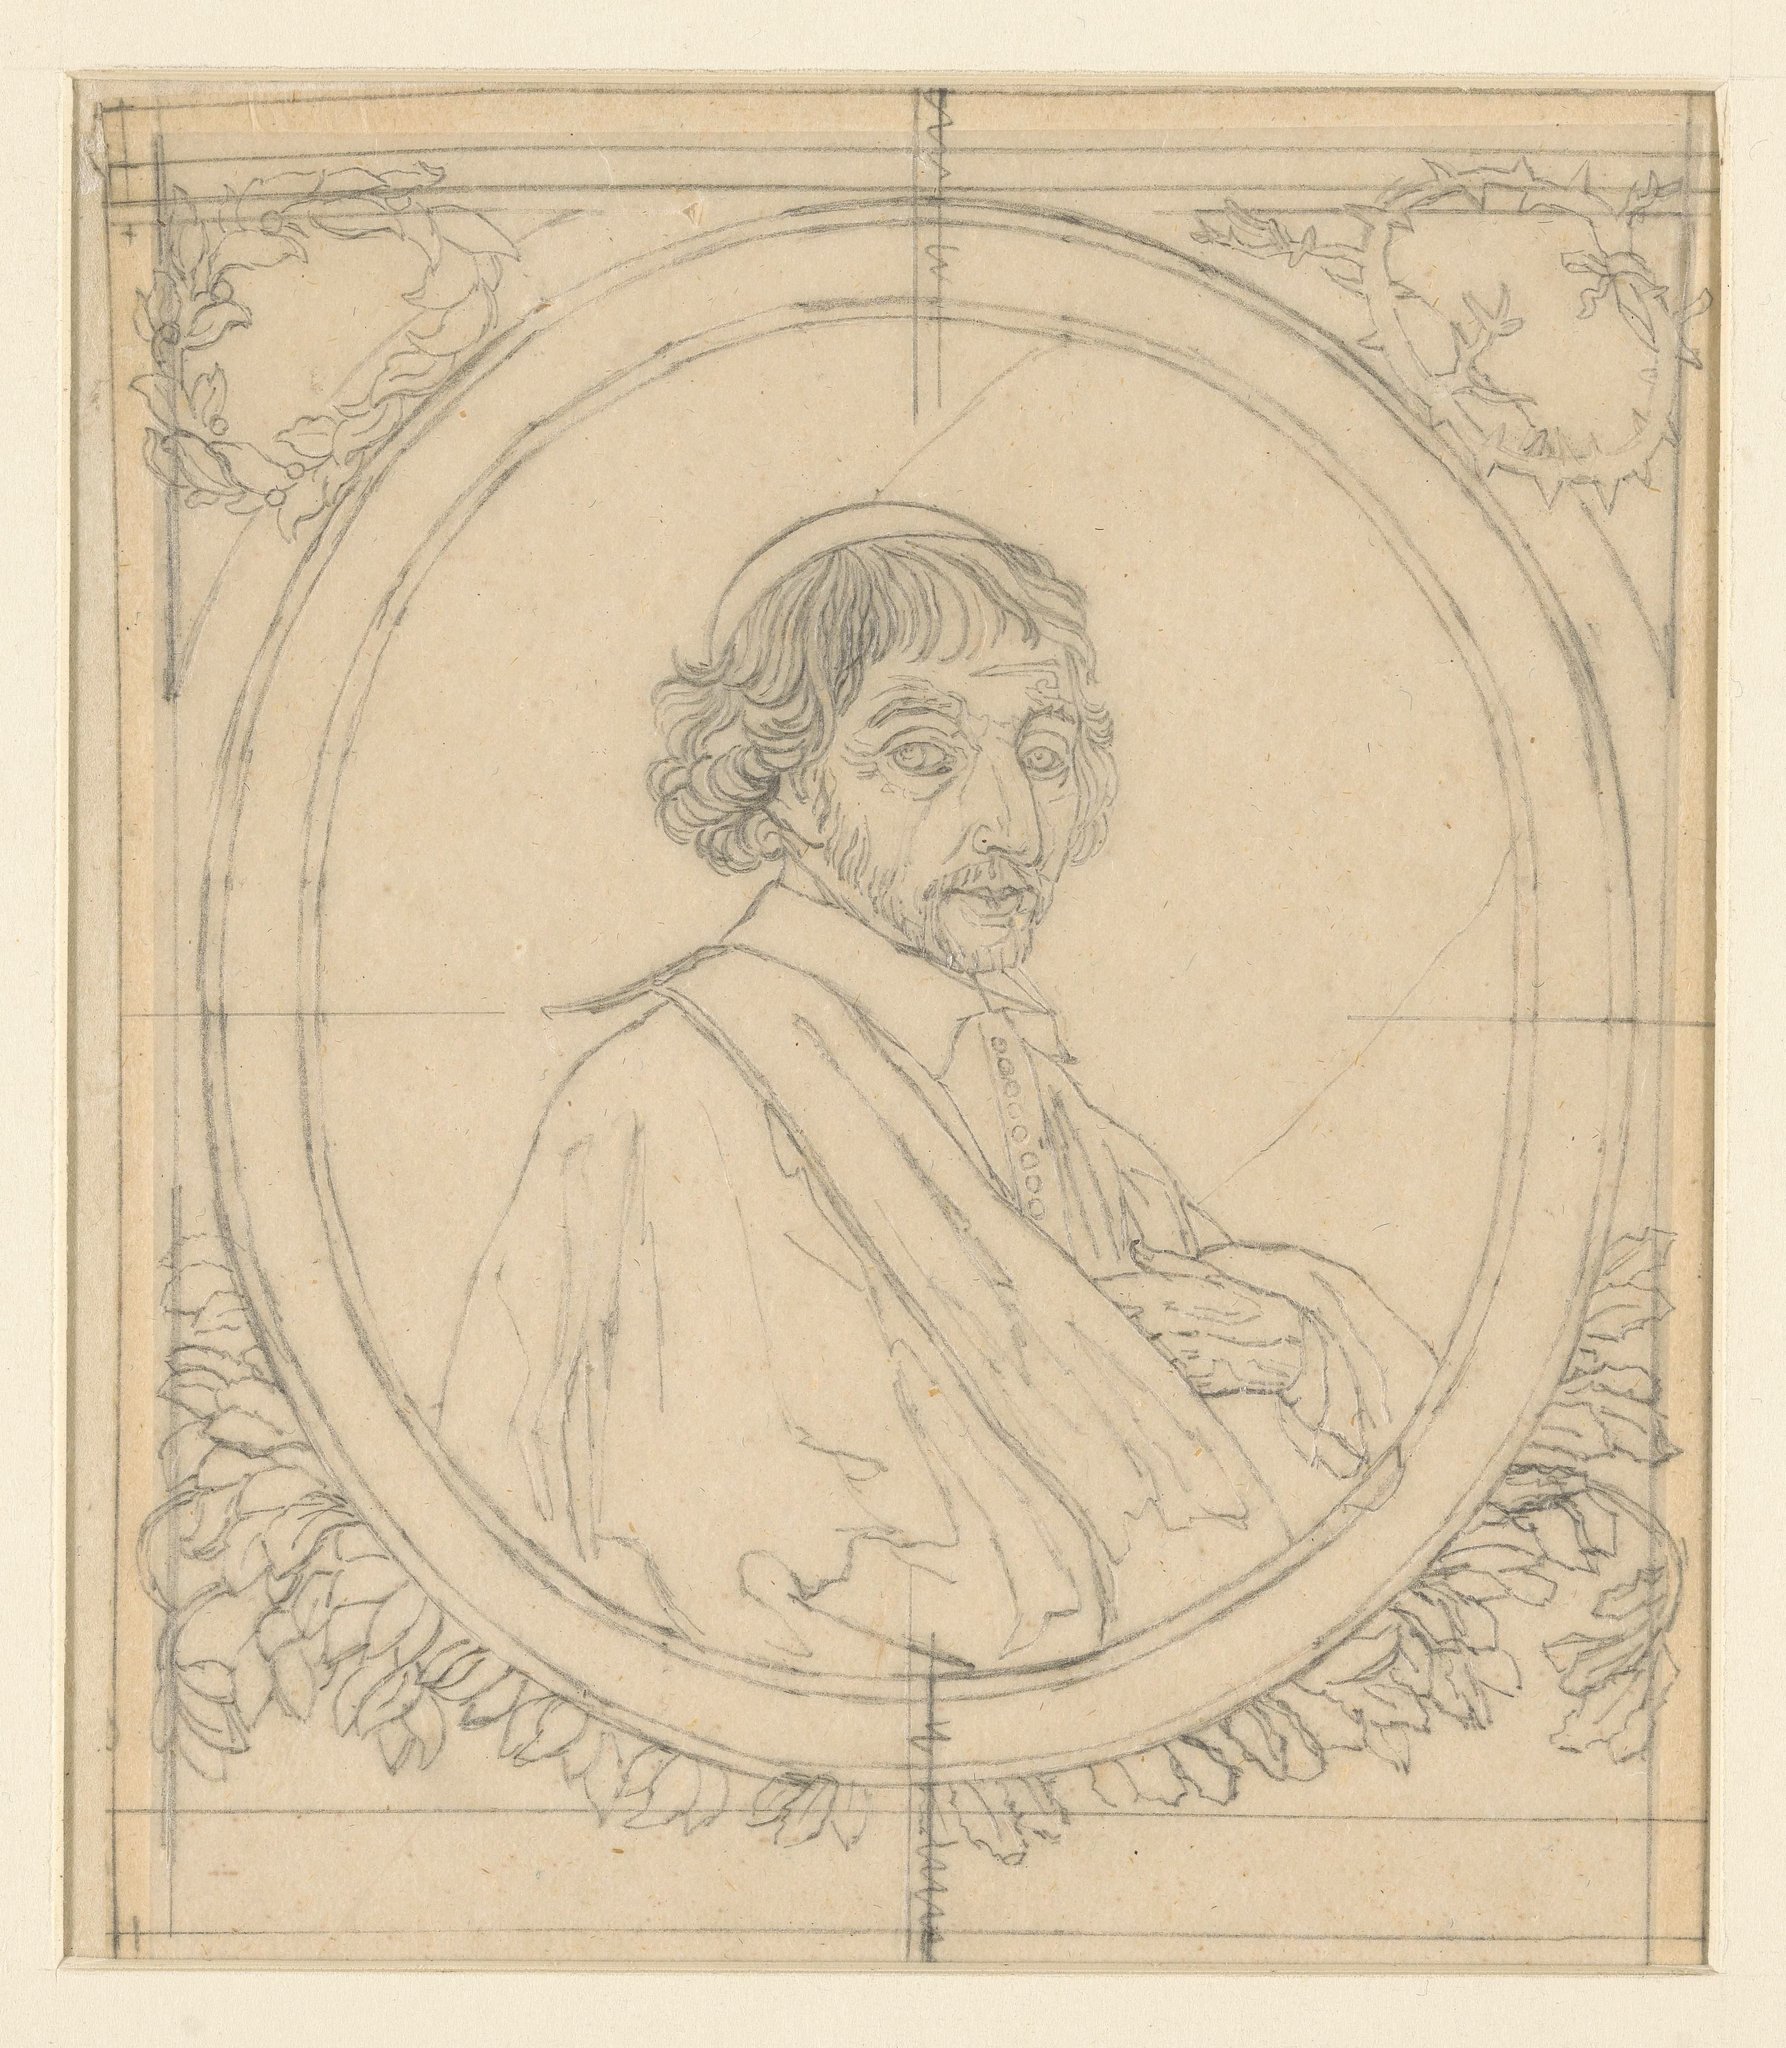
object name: design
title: Portret van Jean de Labadie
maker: frederik hendrik weissenbruch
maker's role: draughtsman, print maker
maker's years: 1828-1887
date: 1838-1887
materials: pencil, paper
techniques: pouncing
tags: historical persons